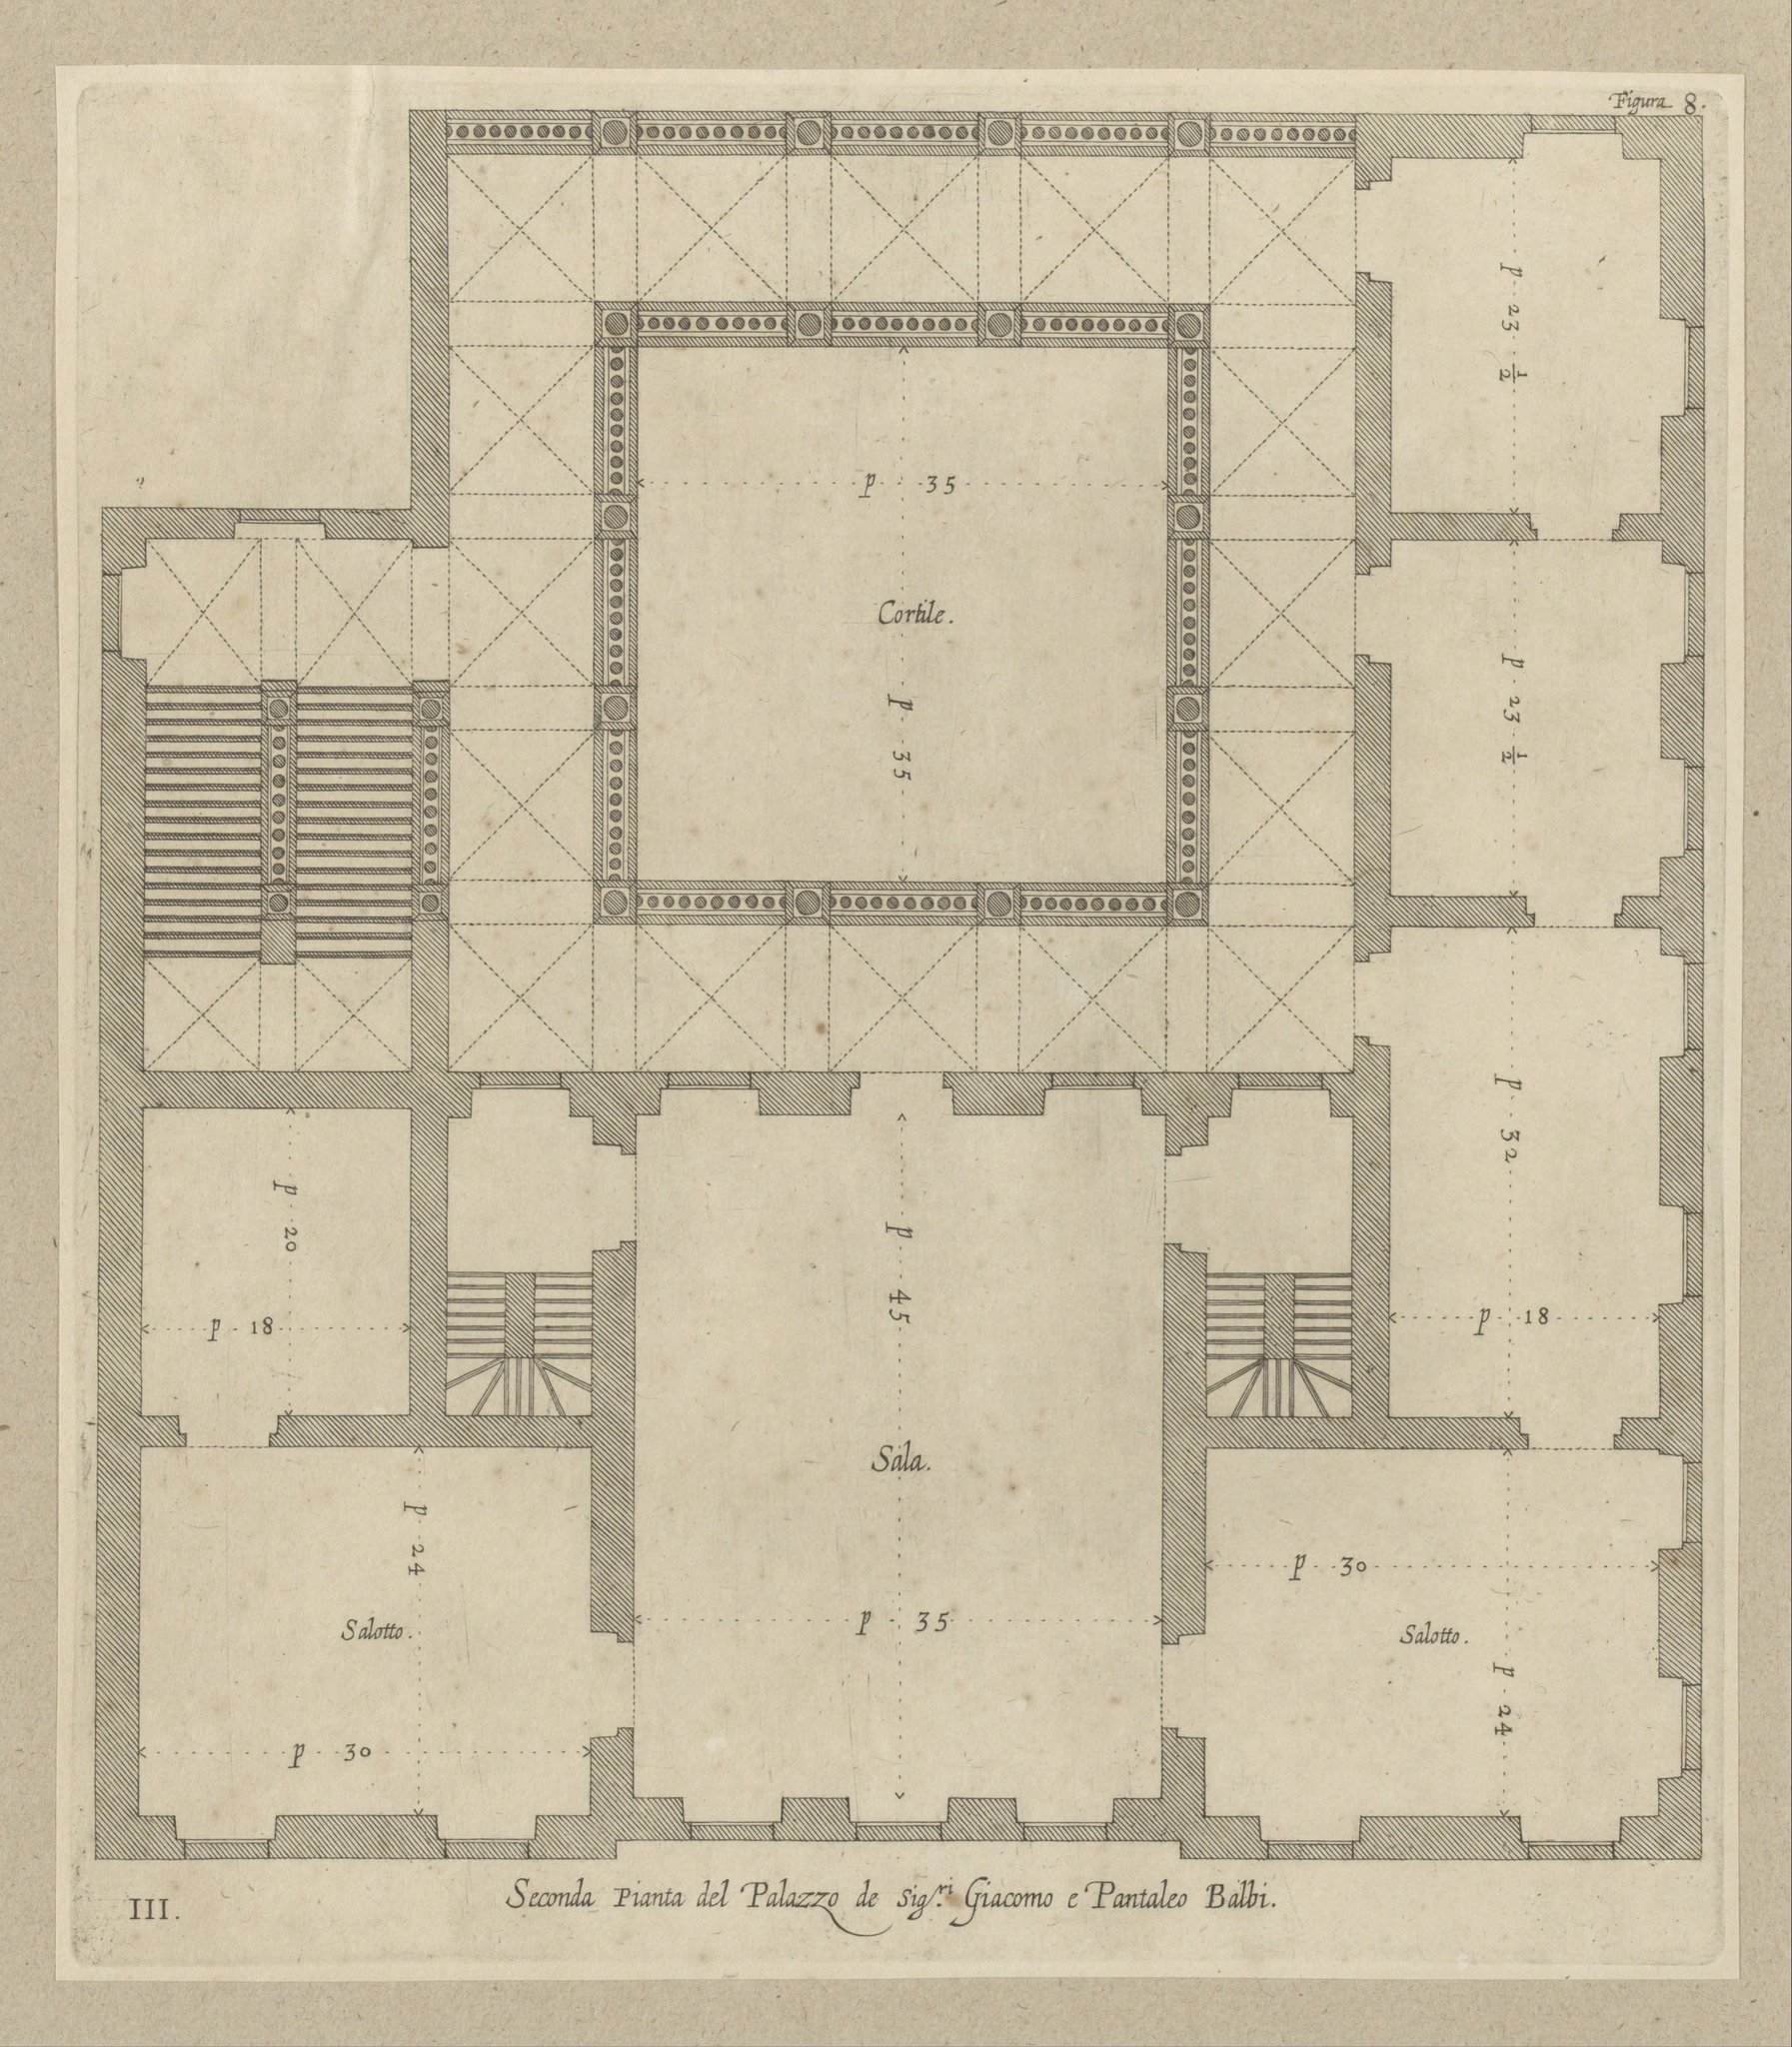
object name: album leaf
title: Prima pianta del Palazzo de gli sig.ri Giacomo e Pantaleo Balbi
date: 1622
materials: paper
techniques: engraving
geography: antwerp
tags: hôtel, i.e. small palace in city - aa - civic architecture: inside, plan ~ architecture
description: Deze prent maakt deel uit van een album.